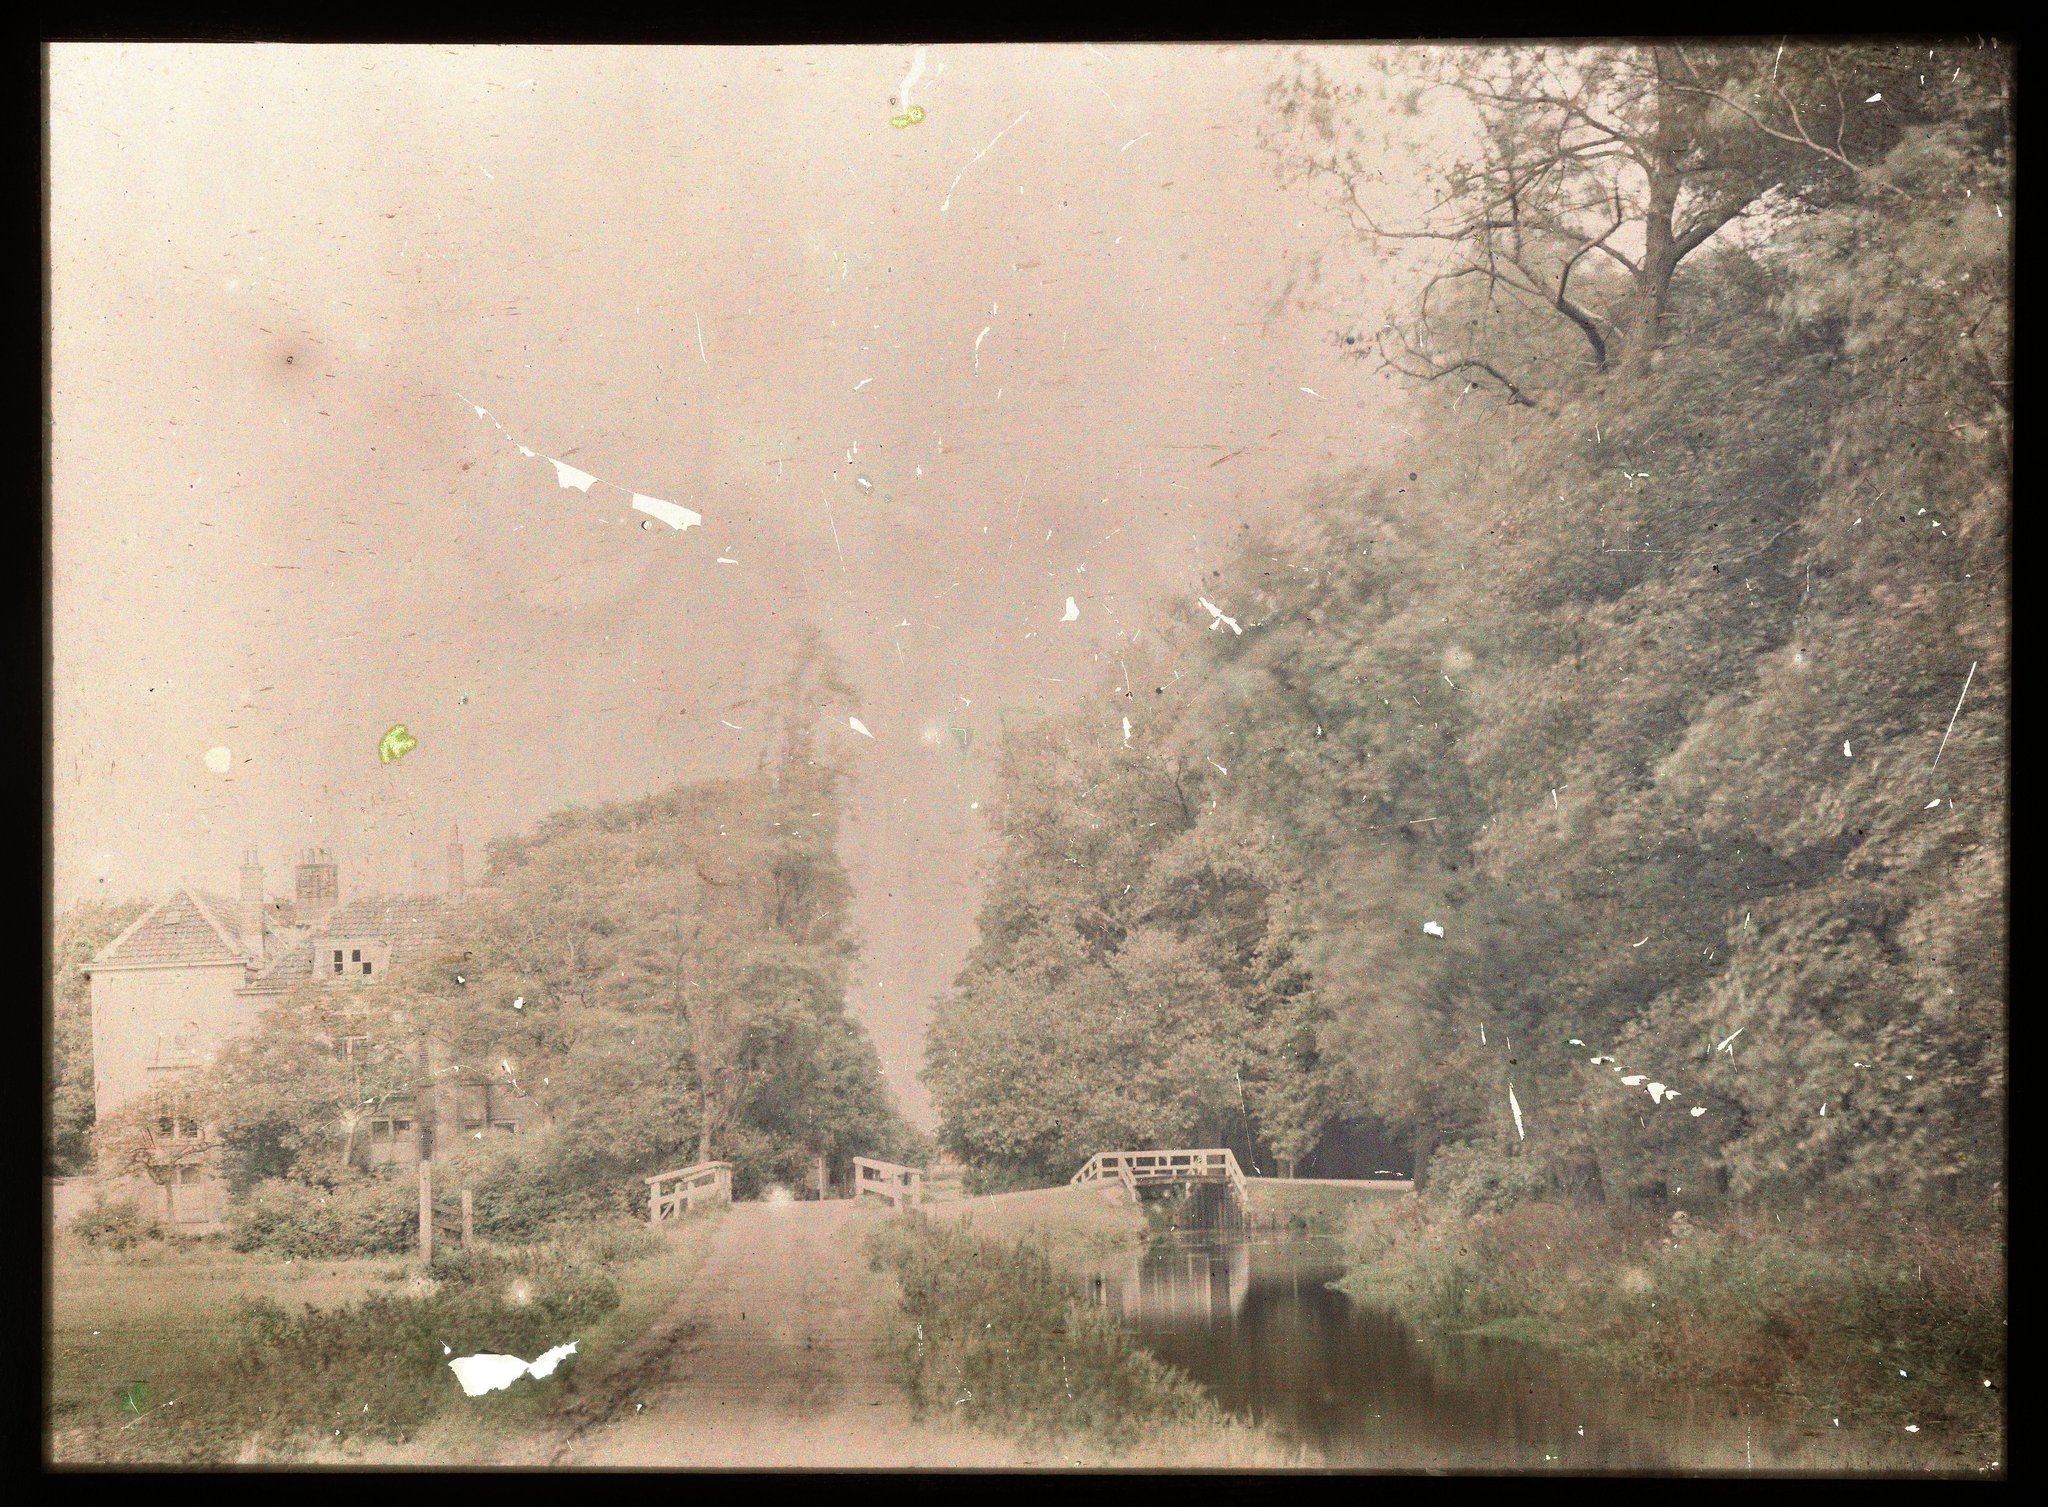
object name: color slide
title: Landschap met landweg en vaart, bruggen en een landhuis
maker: Anonymous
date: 1907-1930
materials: glass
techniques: autochrome process, slide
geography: netherlands